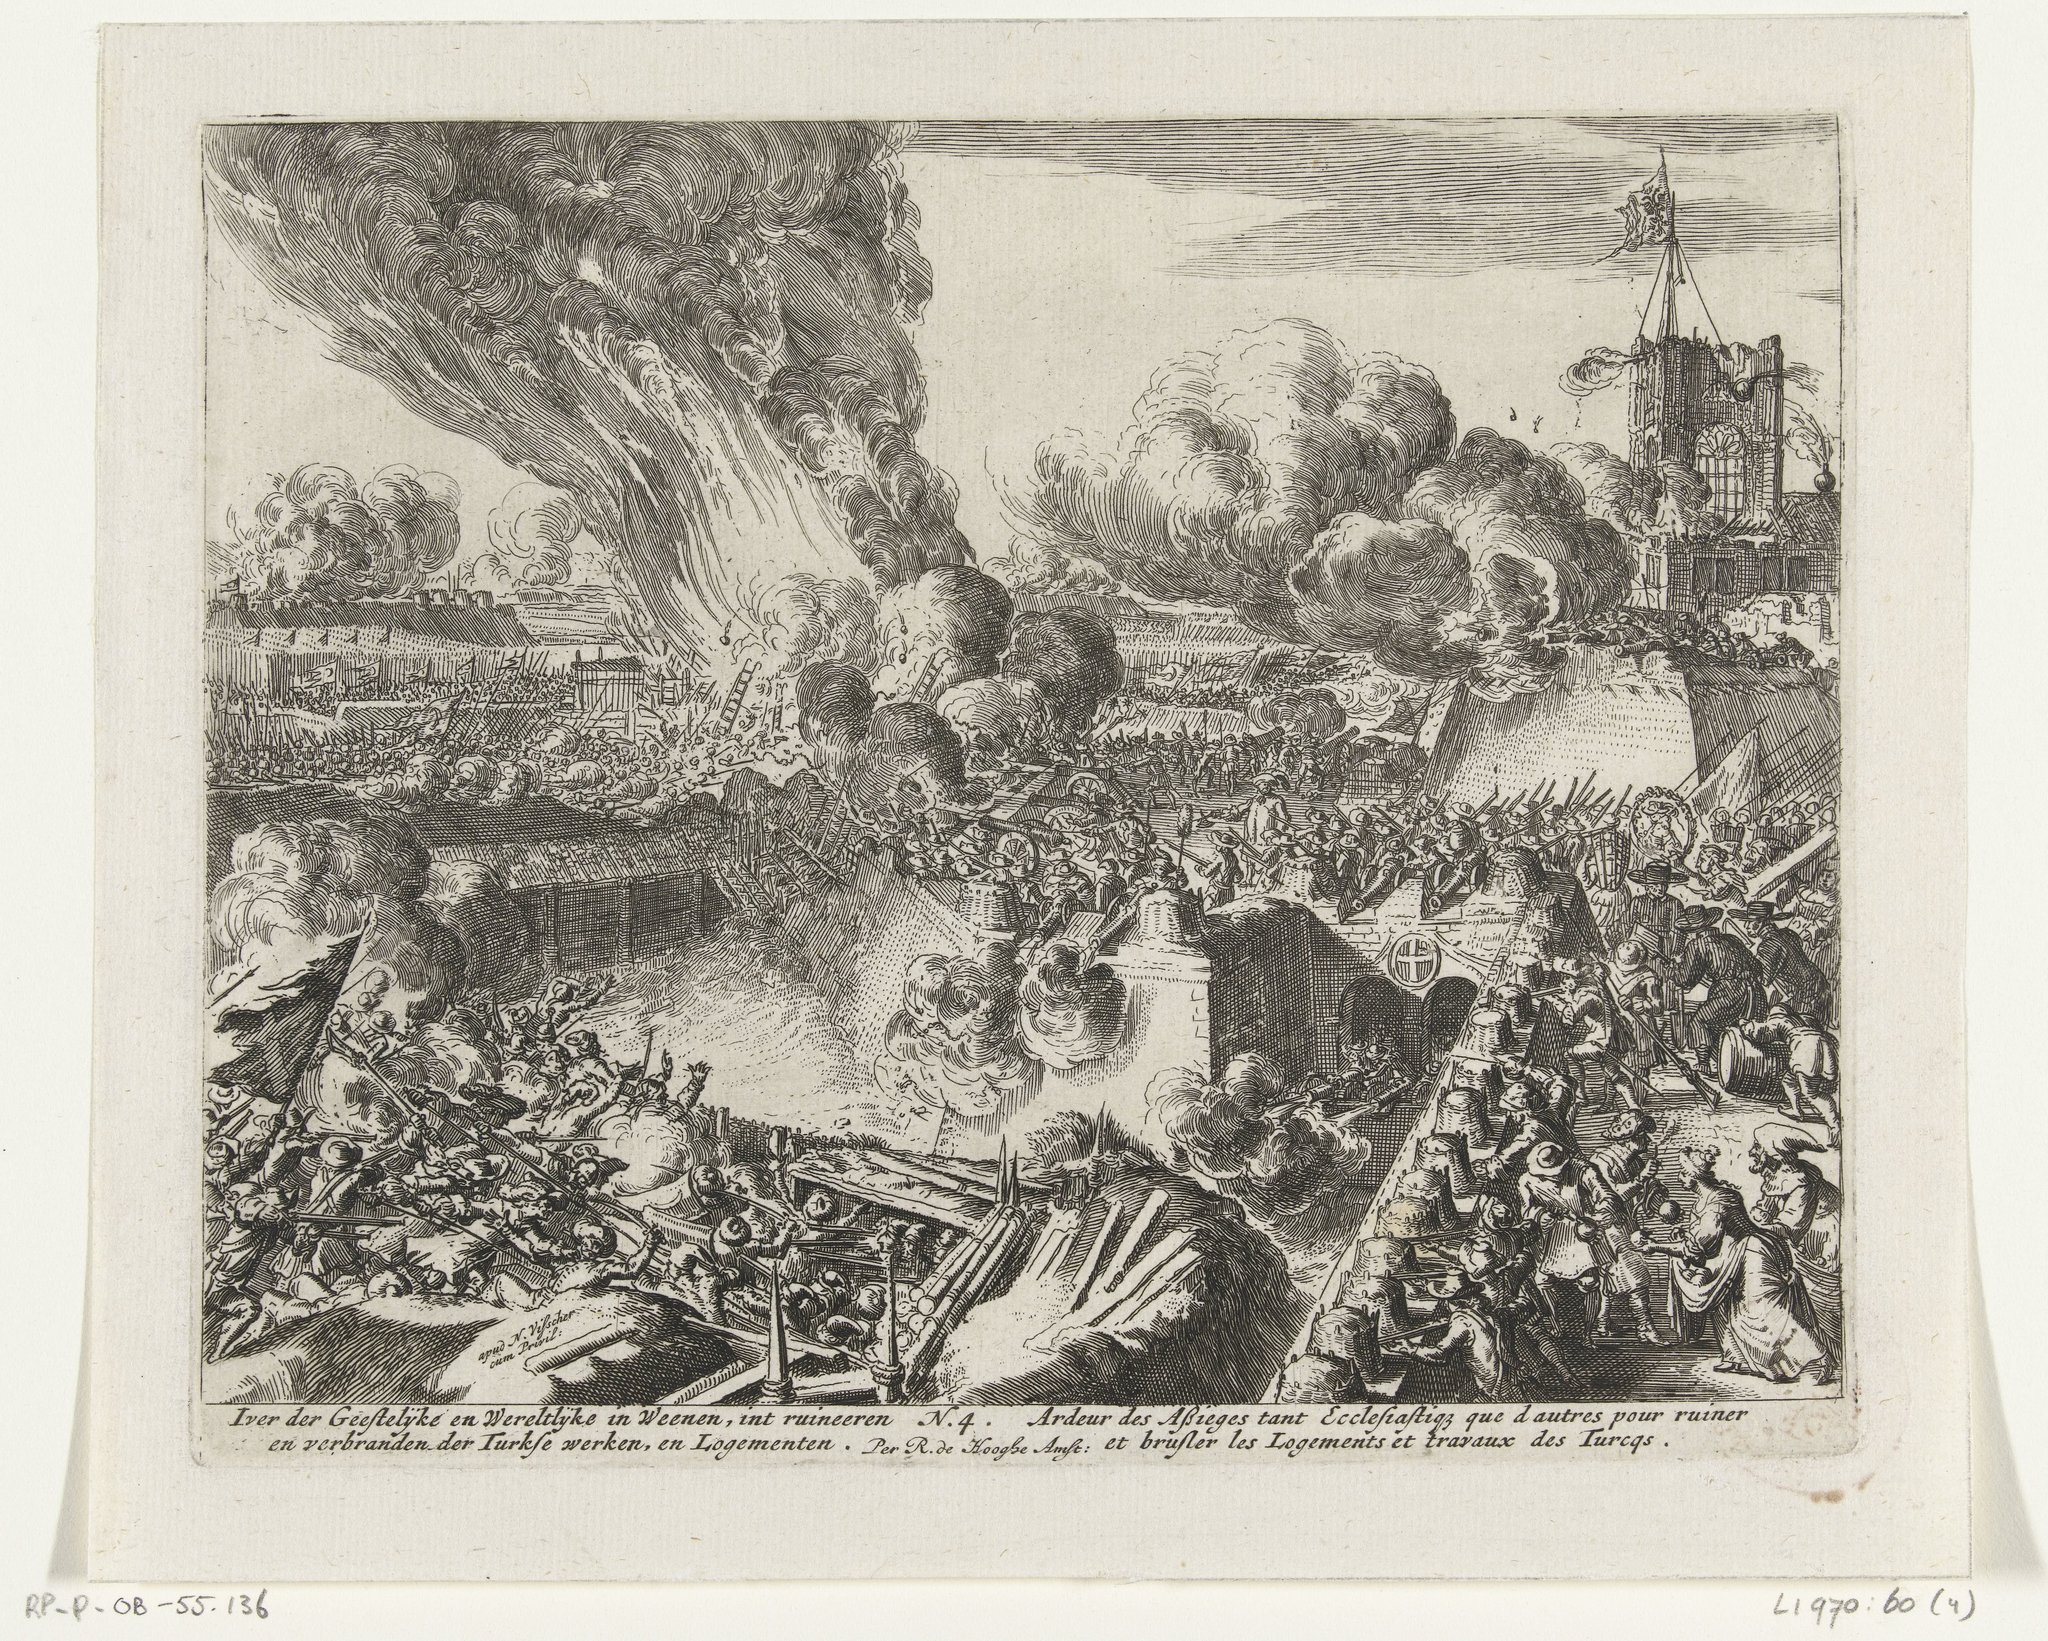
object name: print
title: Habsburgers beschieten Turkse belegeraars vanaf de stadsmuren van Wenen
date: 1684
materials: paper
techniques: engraving, etching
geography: amsterdam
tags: jan iii sobieski (koning van polen), vienna, leopold i (keizer van duitsland), siege, position war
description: Illustratie voor Johann van Ghelen, Relation succinte et veritable de tout ce qui s'est passé pendant le siege de Vienne, residence de Sa Majesté Imperiale, assiegée par les Turcs depuis le 14. juillet jusqu'au 12. de septembre 1683., Bruxelles: Jean Leonard, 1684.